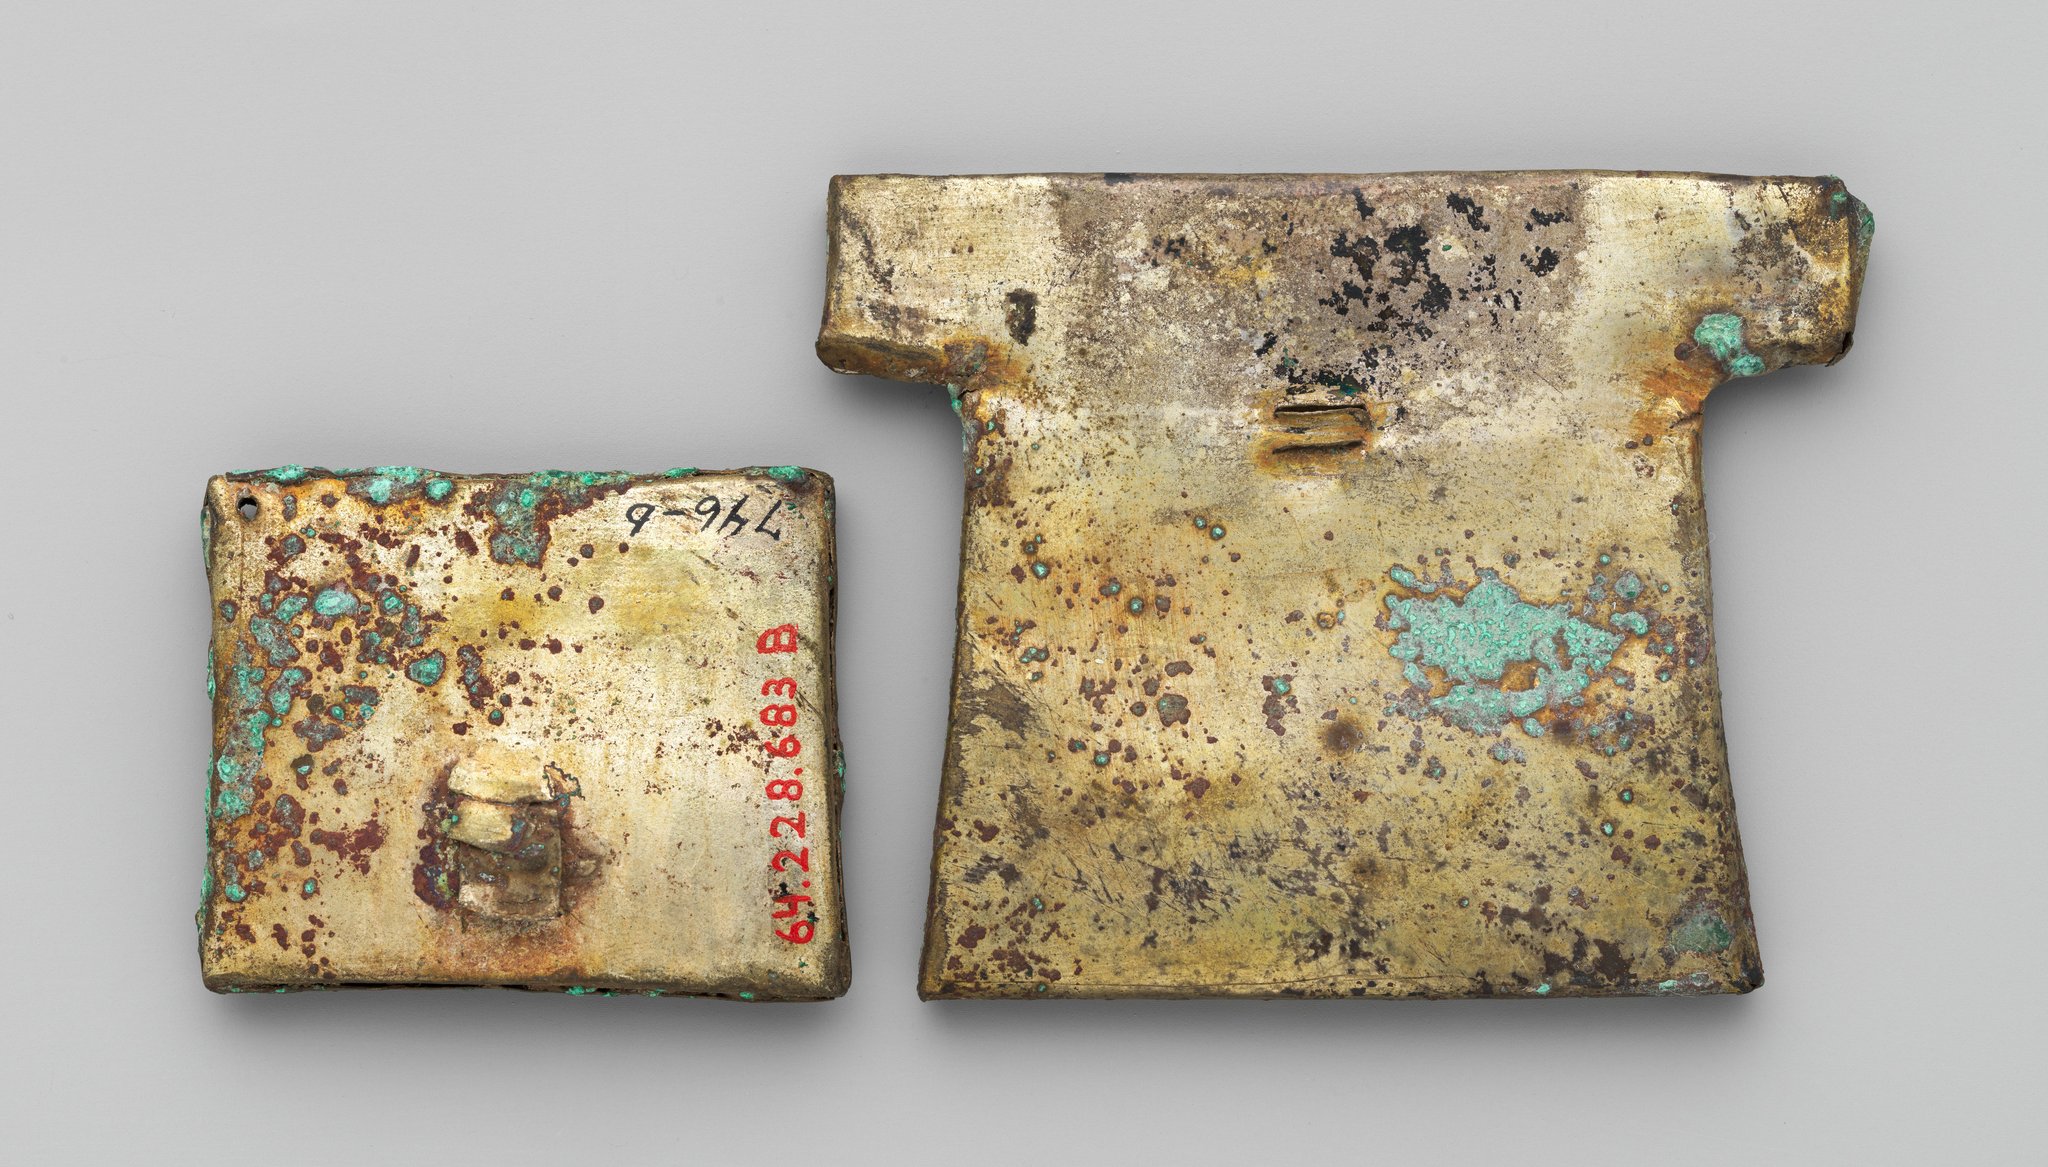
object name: litter backrest and pillow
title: Miniature Litter Section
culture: chancay or chimú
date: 1001-1500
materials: gilt, silver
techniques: hammering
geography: peru